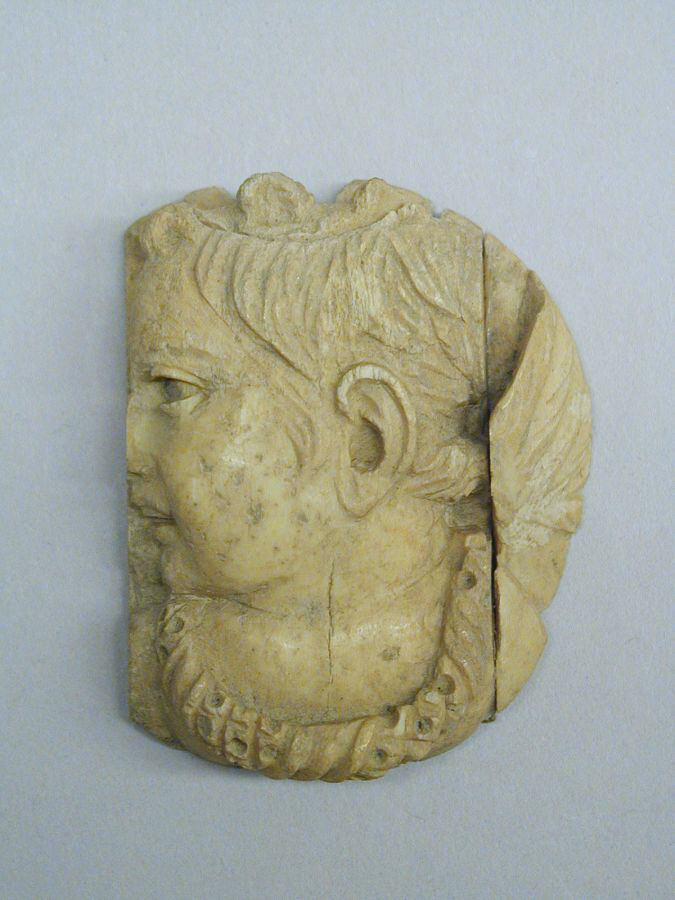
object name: relief from couch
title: Ivory furniture attachment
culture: roman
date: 1-33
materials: ivory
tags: heads,eros